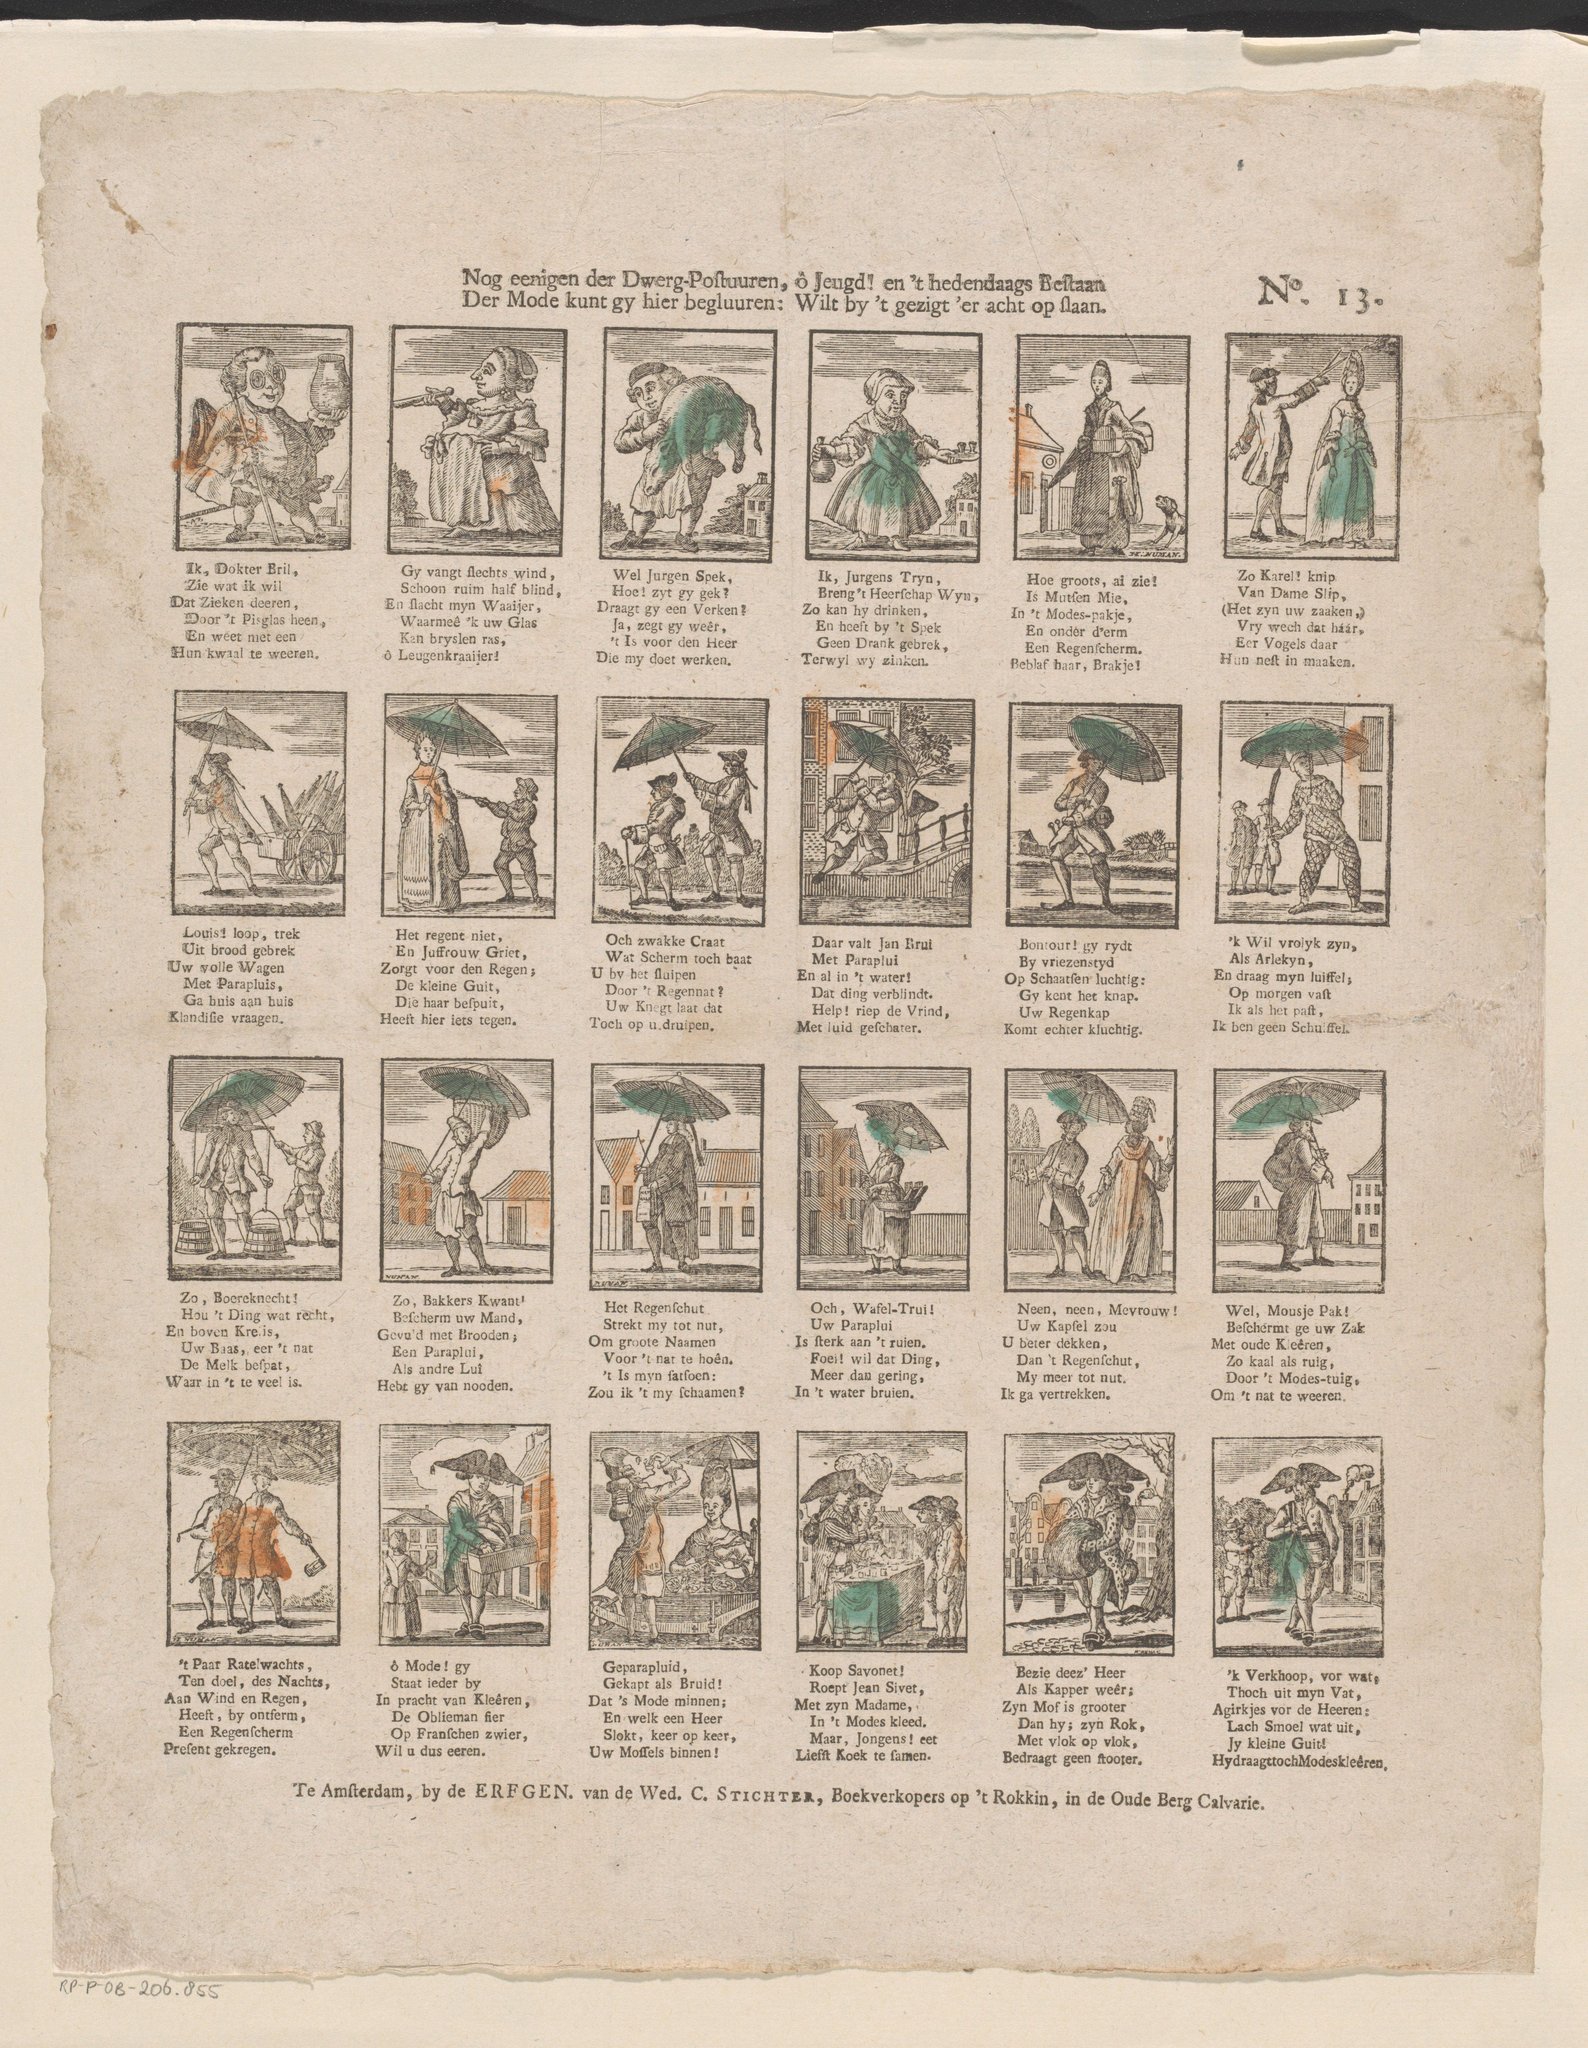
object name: cartoon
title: Nog eenigen der dwerg-postuuren, ô jeugd! en 't hedendaags bestaan / Der mode kunt gy hier begluuren: Wilt by 't gezigt 'er acht op slaan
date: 1715-1813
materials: paper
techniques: colour, letterpress printing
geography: amsterdam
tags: styles of hairdress, umbrella, wig, fashion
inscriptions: collector's mark: Lugt 2760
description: Blad met 24 spottende voorstellingen op hoge kapsels, paraplu's en vreemde mode. Onder elke afbeelding een zesregelig vers. Genummerd rechtsboven: No. 13.